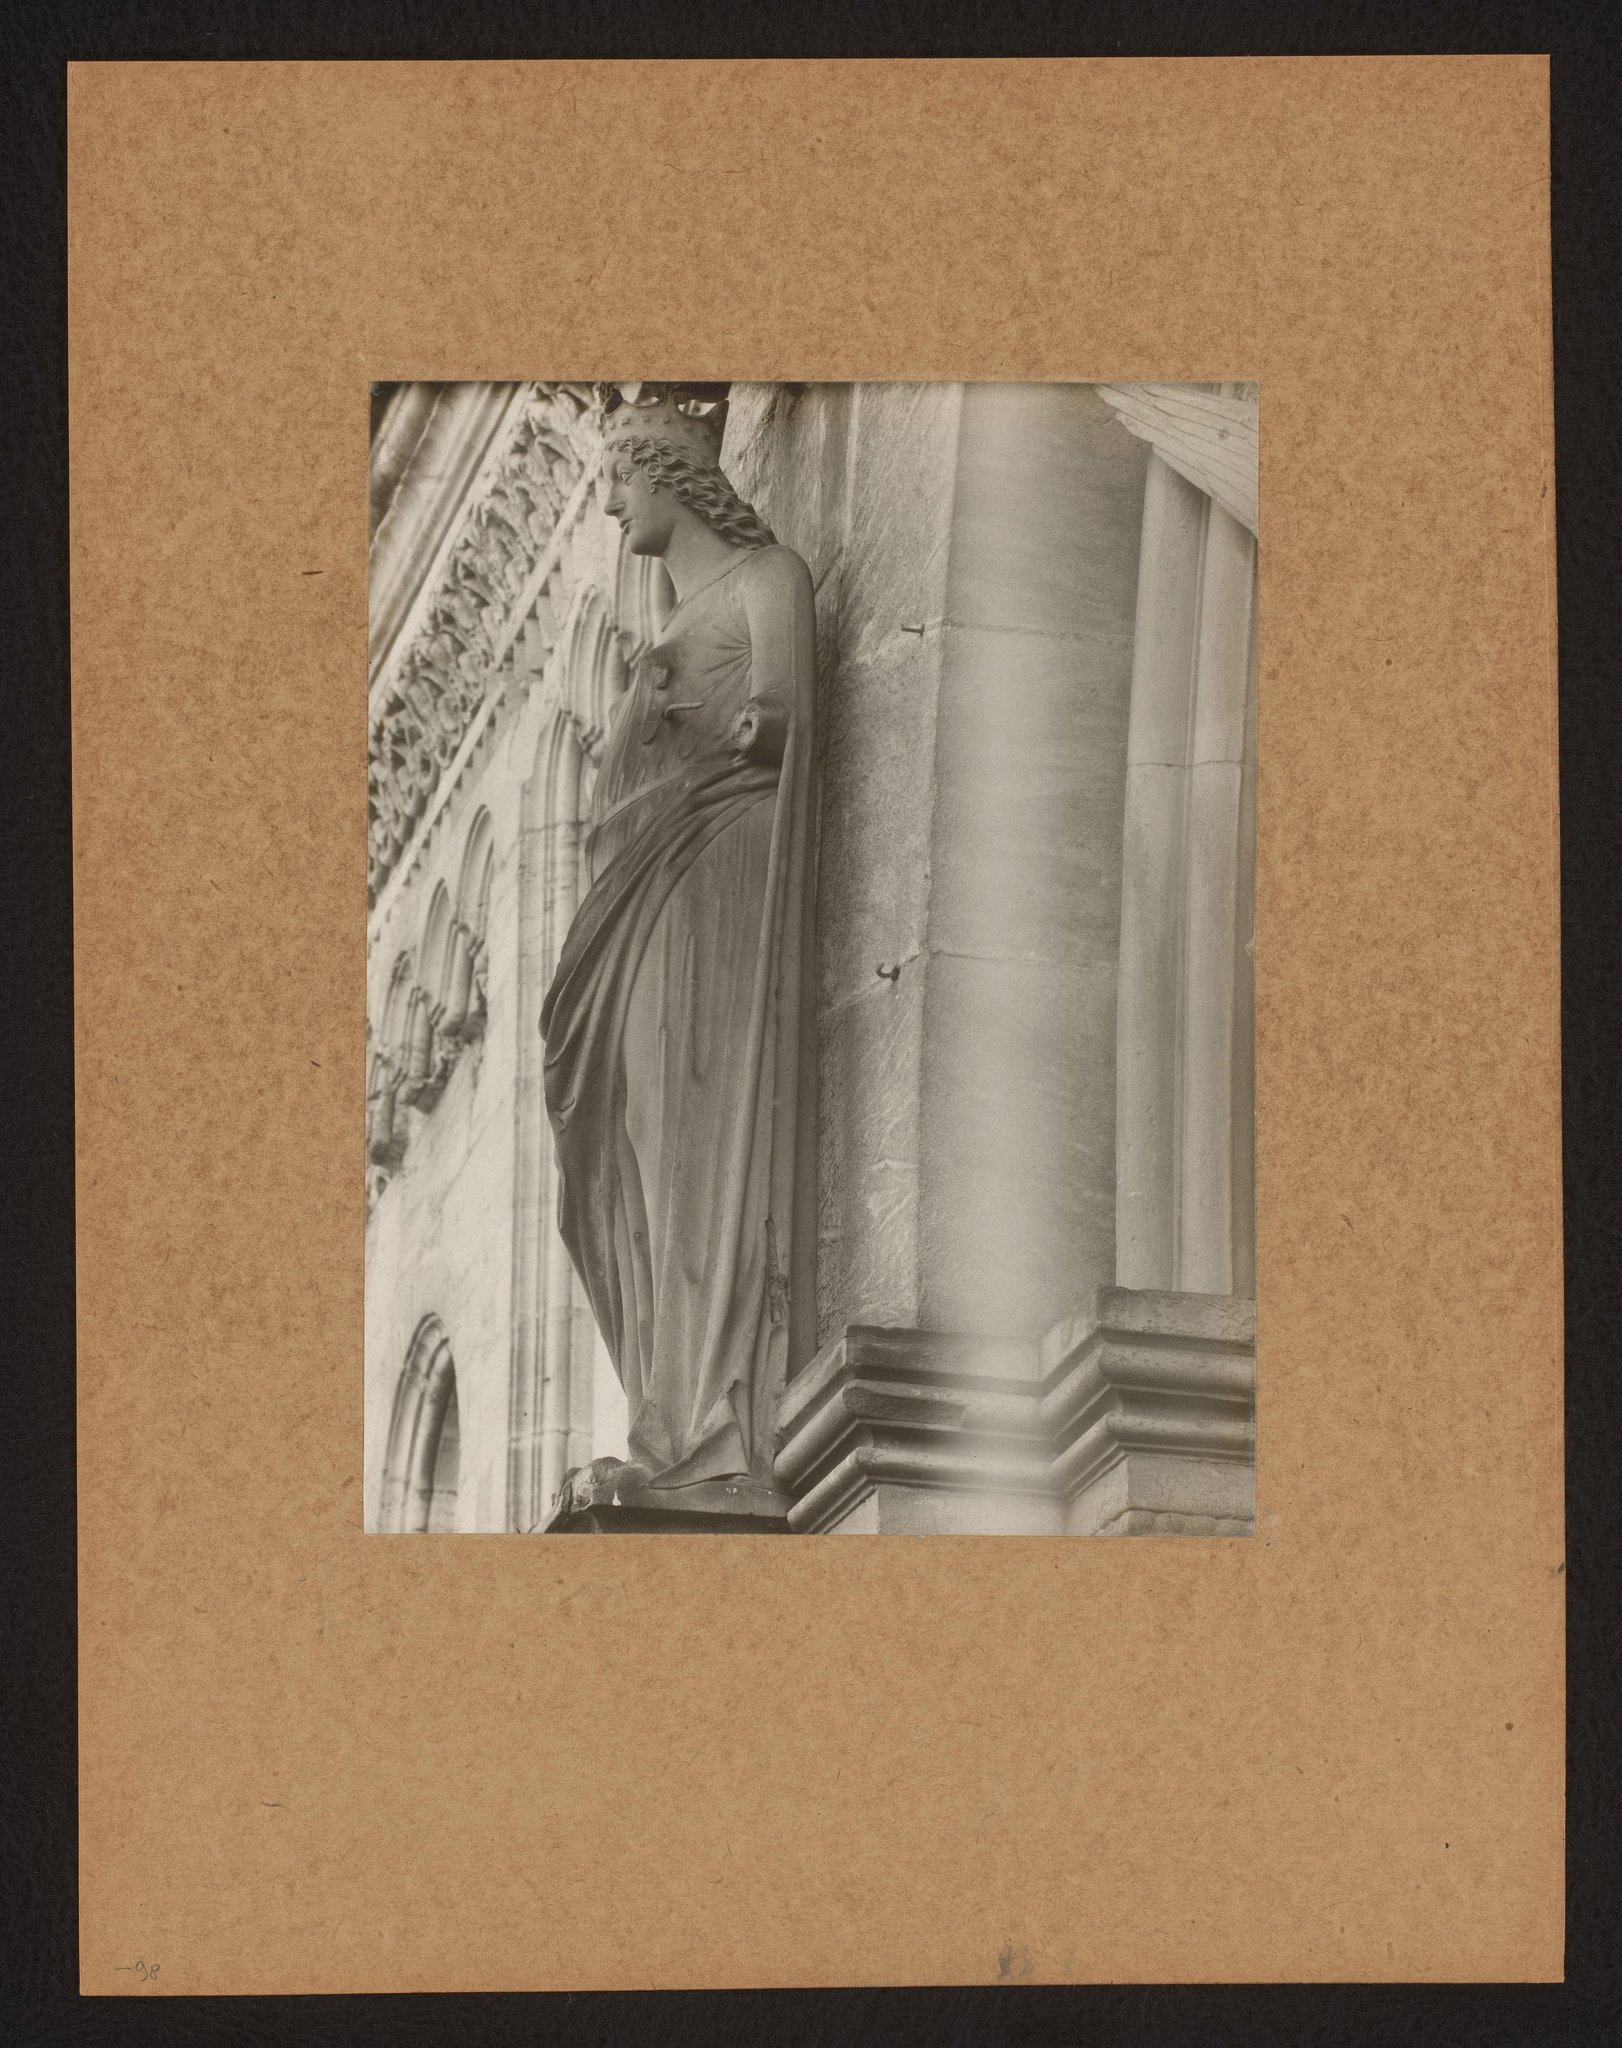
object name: photograph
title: Detail van het Fürstenportal in de dom van Bamberg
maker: Anonymous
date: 1900-1920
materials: paper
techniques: gelatin silver print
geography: bamberg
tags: church (exterior)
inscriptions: number: ‘101’